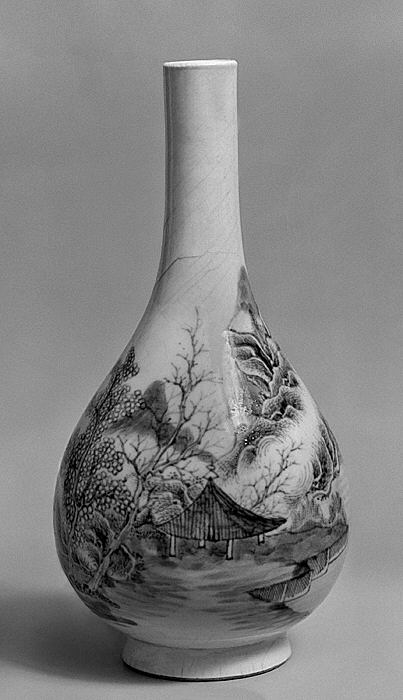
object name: vase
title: Vase with landscape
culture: chinese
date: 1767-1800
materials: cobalt, soft paste porcelain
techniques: painting, underglaze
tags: landscapes